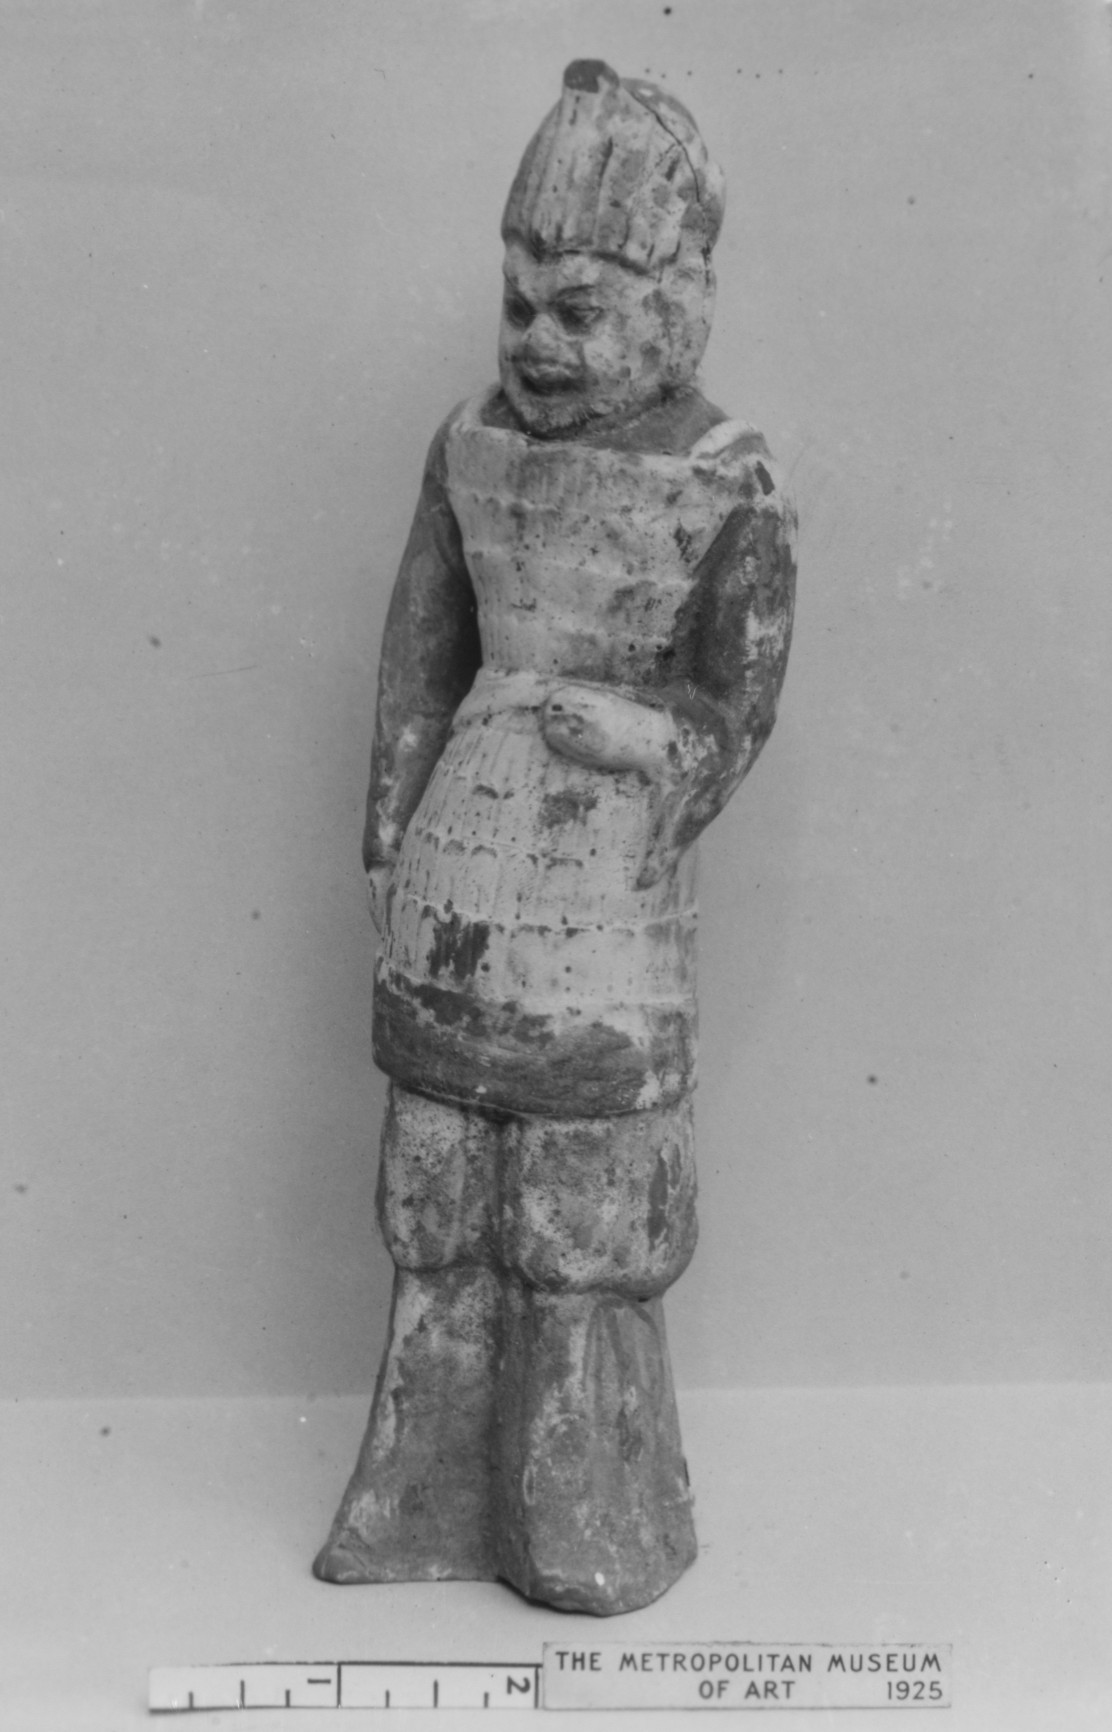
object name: figure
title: Armored warrior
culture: chinese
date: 386-534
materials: earthenware, pigment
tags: armor,men